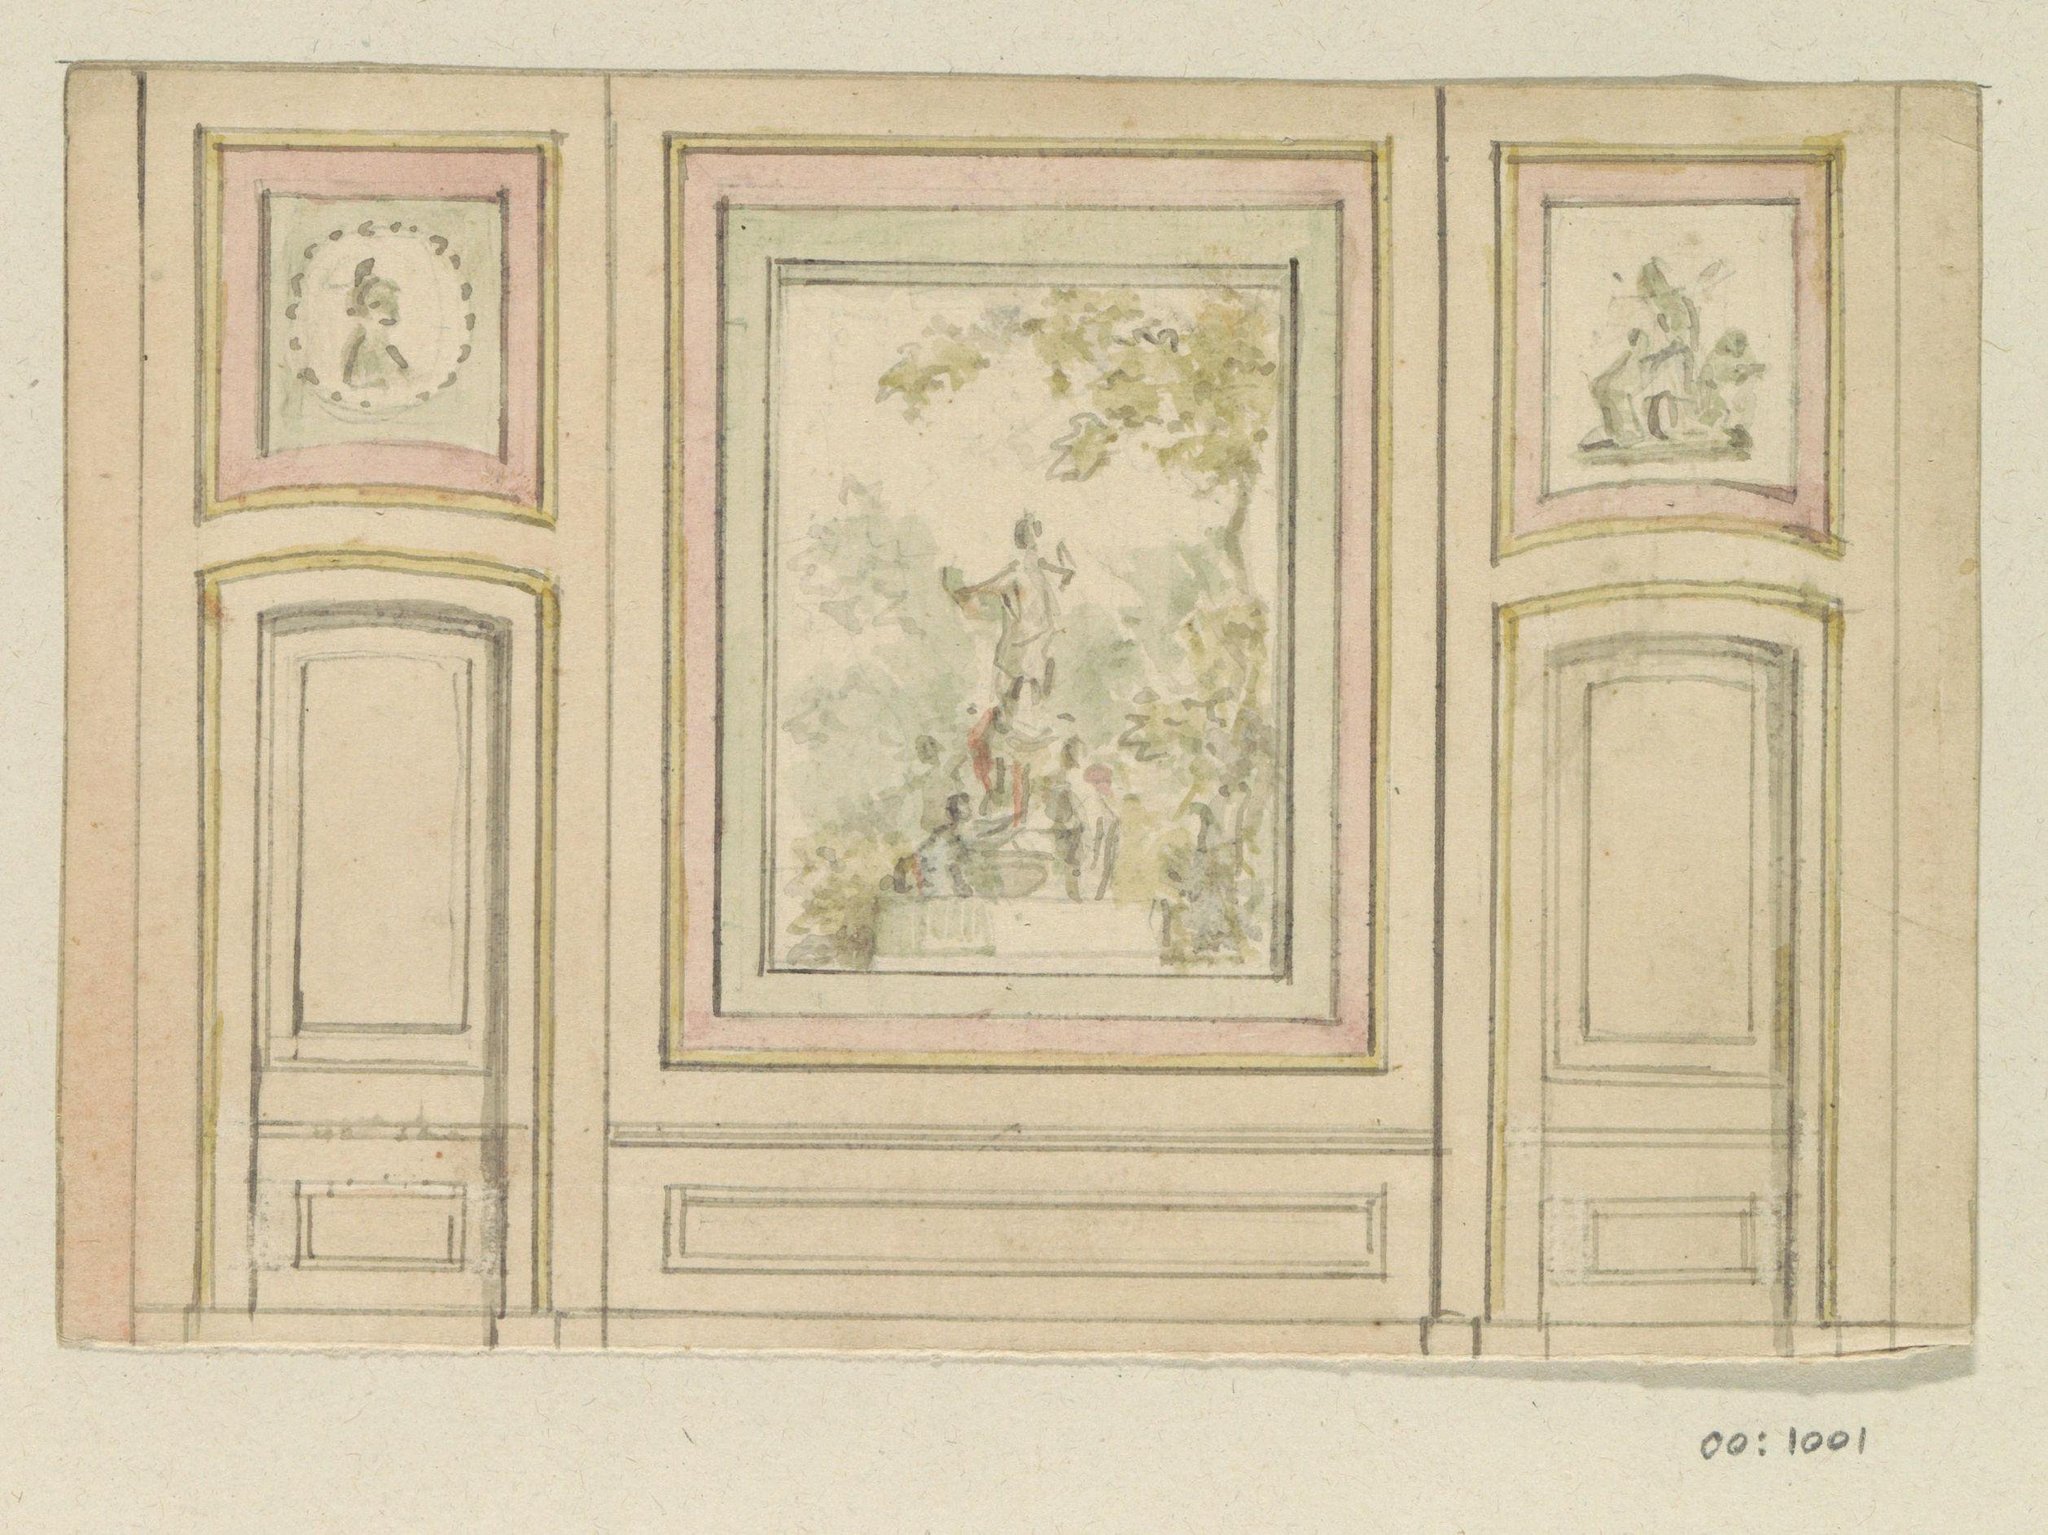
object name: drawing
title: Ontwerptekening voor een kamerwand met twee deuren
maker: jurriaan andriessen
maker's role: draughtsman, painter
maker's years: 1742-1819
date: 1760-1819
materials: paint, paper, pencil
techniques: brush, pen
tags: monument, statue, wall-covering